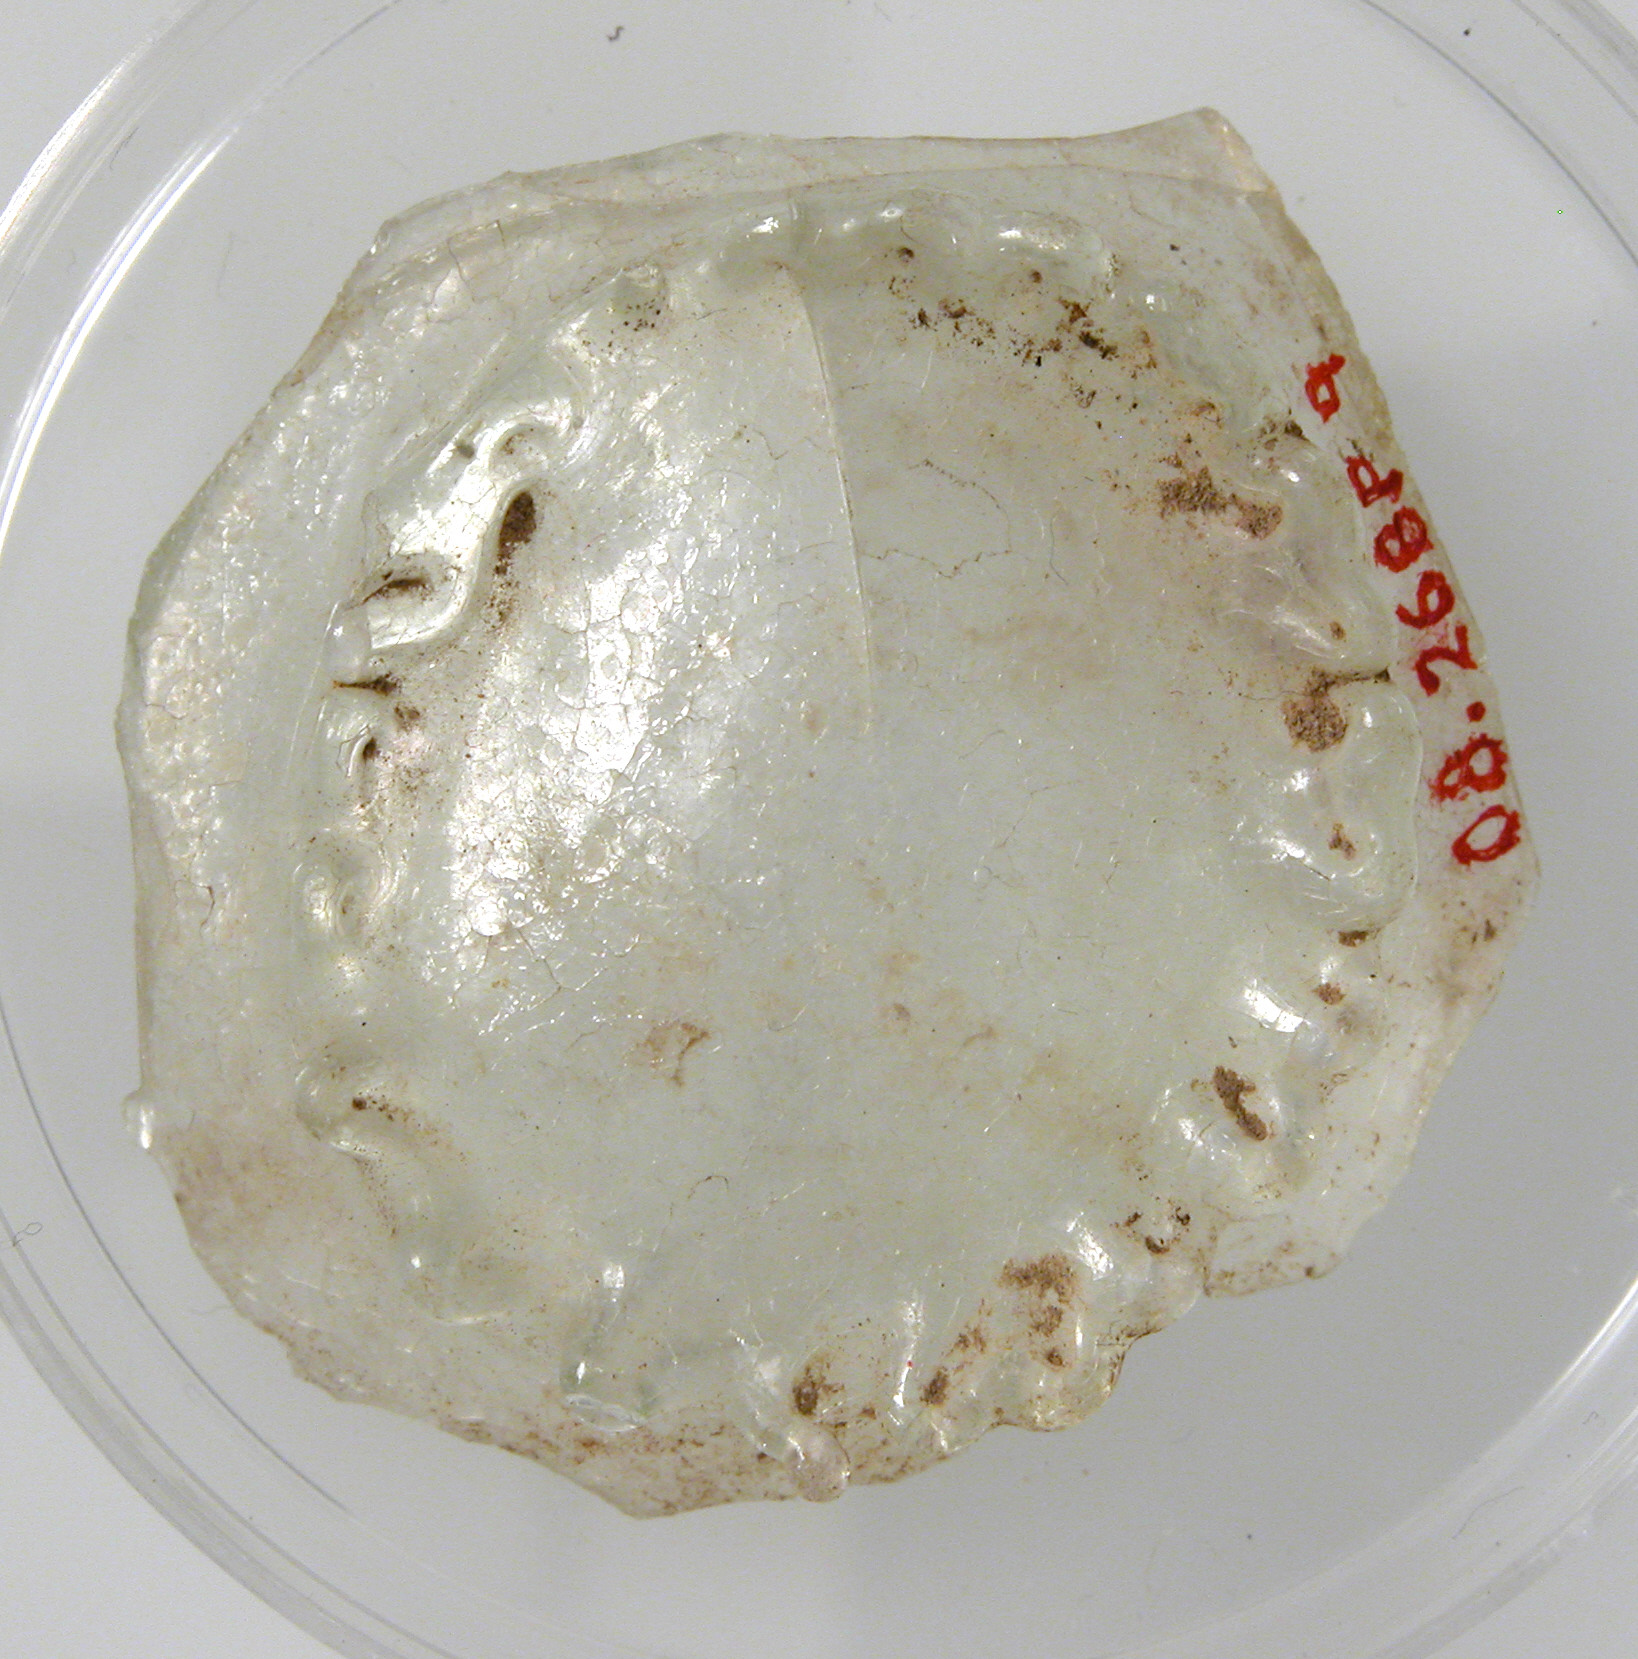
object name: fragment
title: Bottom of a Vessel with Foot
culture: coptic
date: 301-433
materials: glass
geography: egypt